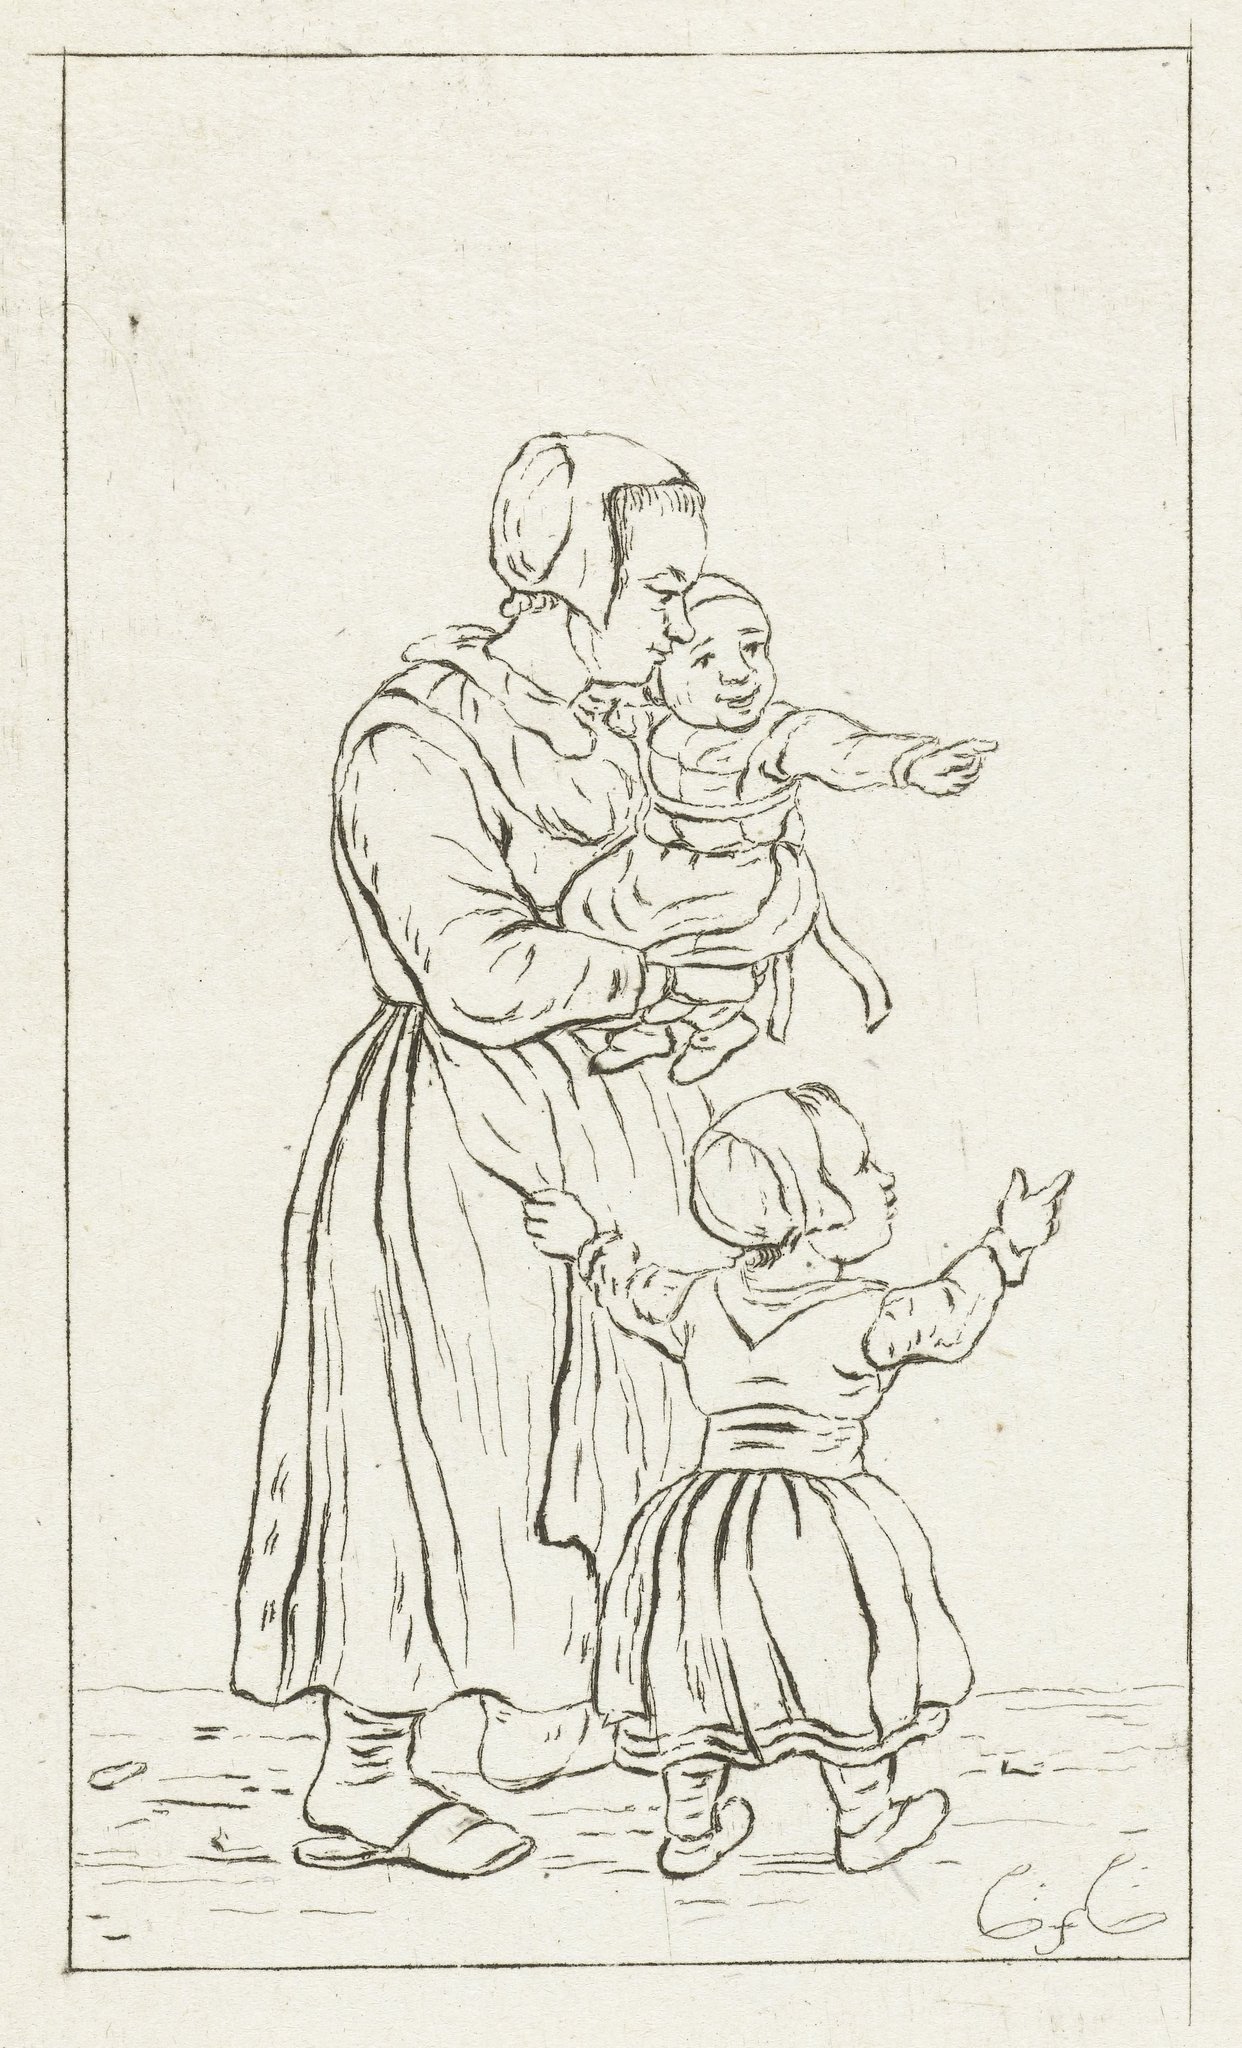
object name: print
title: Moeder met twee kinderen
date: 1779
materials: paper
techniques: etching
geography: leiden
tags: mother and child(ren), woman and child(ren) (family group) (with number of children)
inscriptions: collector's mark: Lugt 2228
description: Een moeder met twee kinderen, naar rechts. Het jongste kind wordt op de arm gedragen. Het oudste kind is een meisje. Ze trekt aan haar moeders schort.